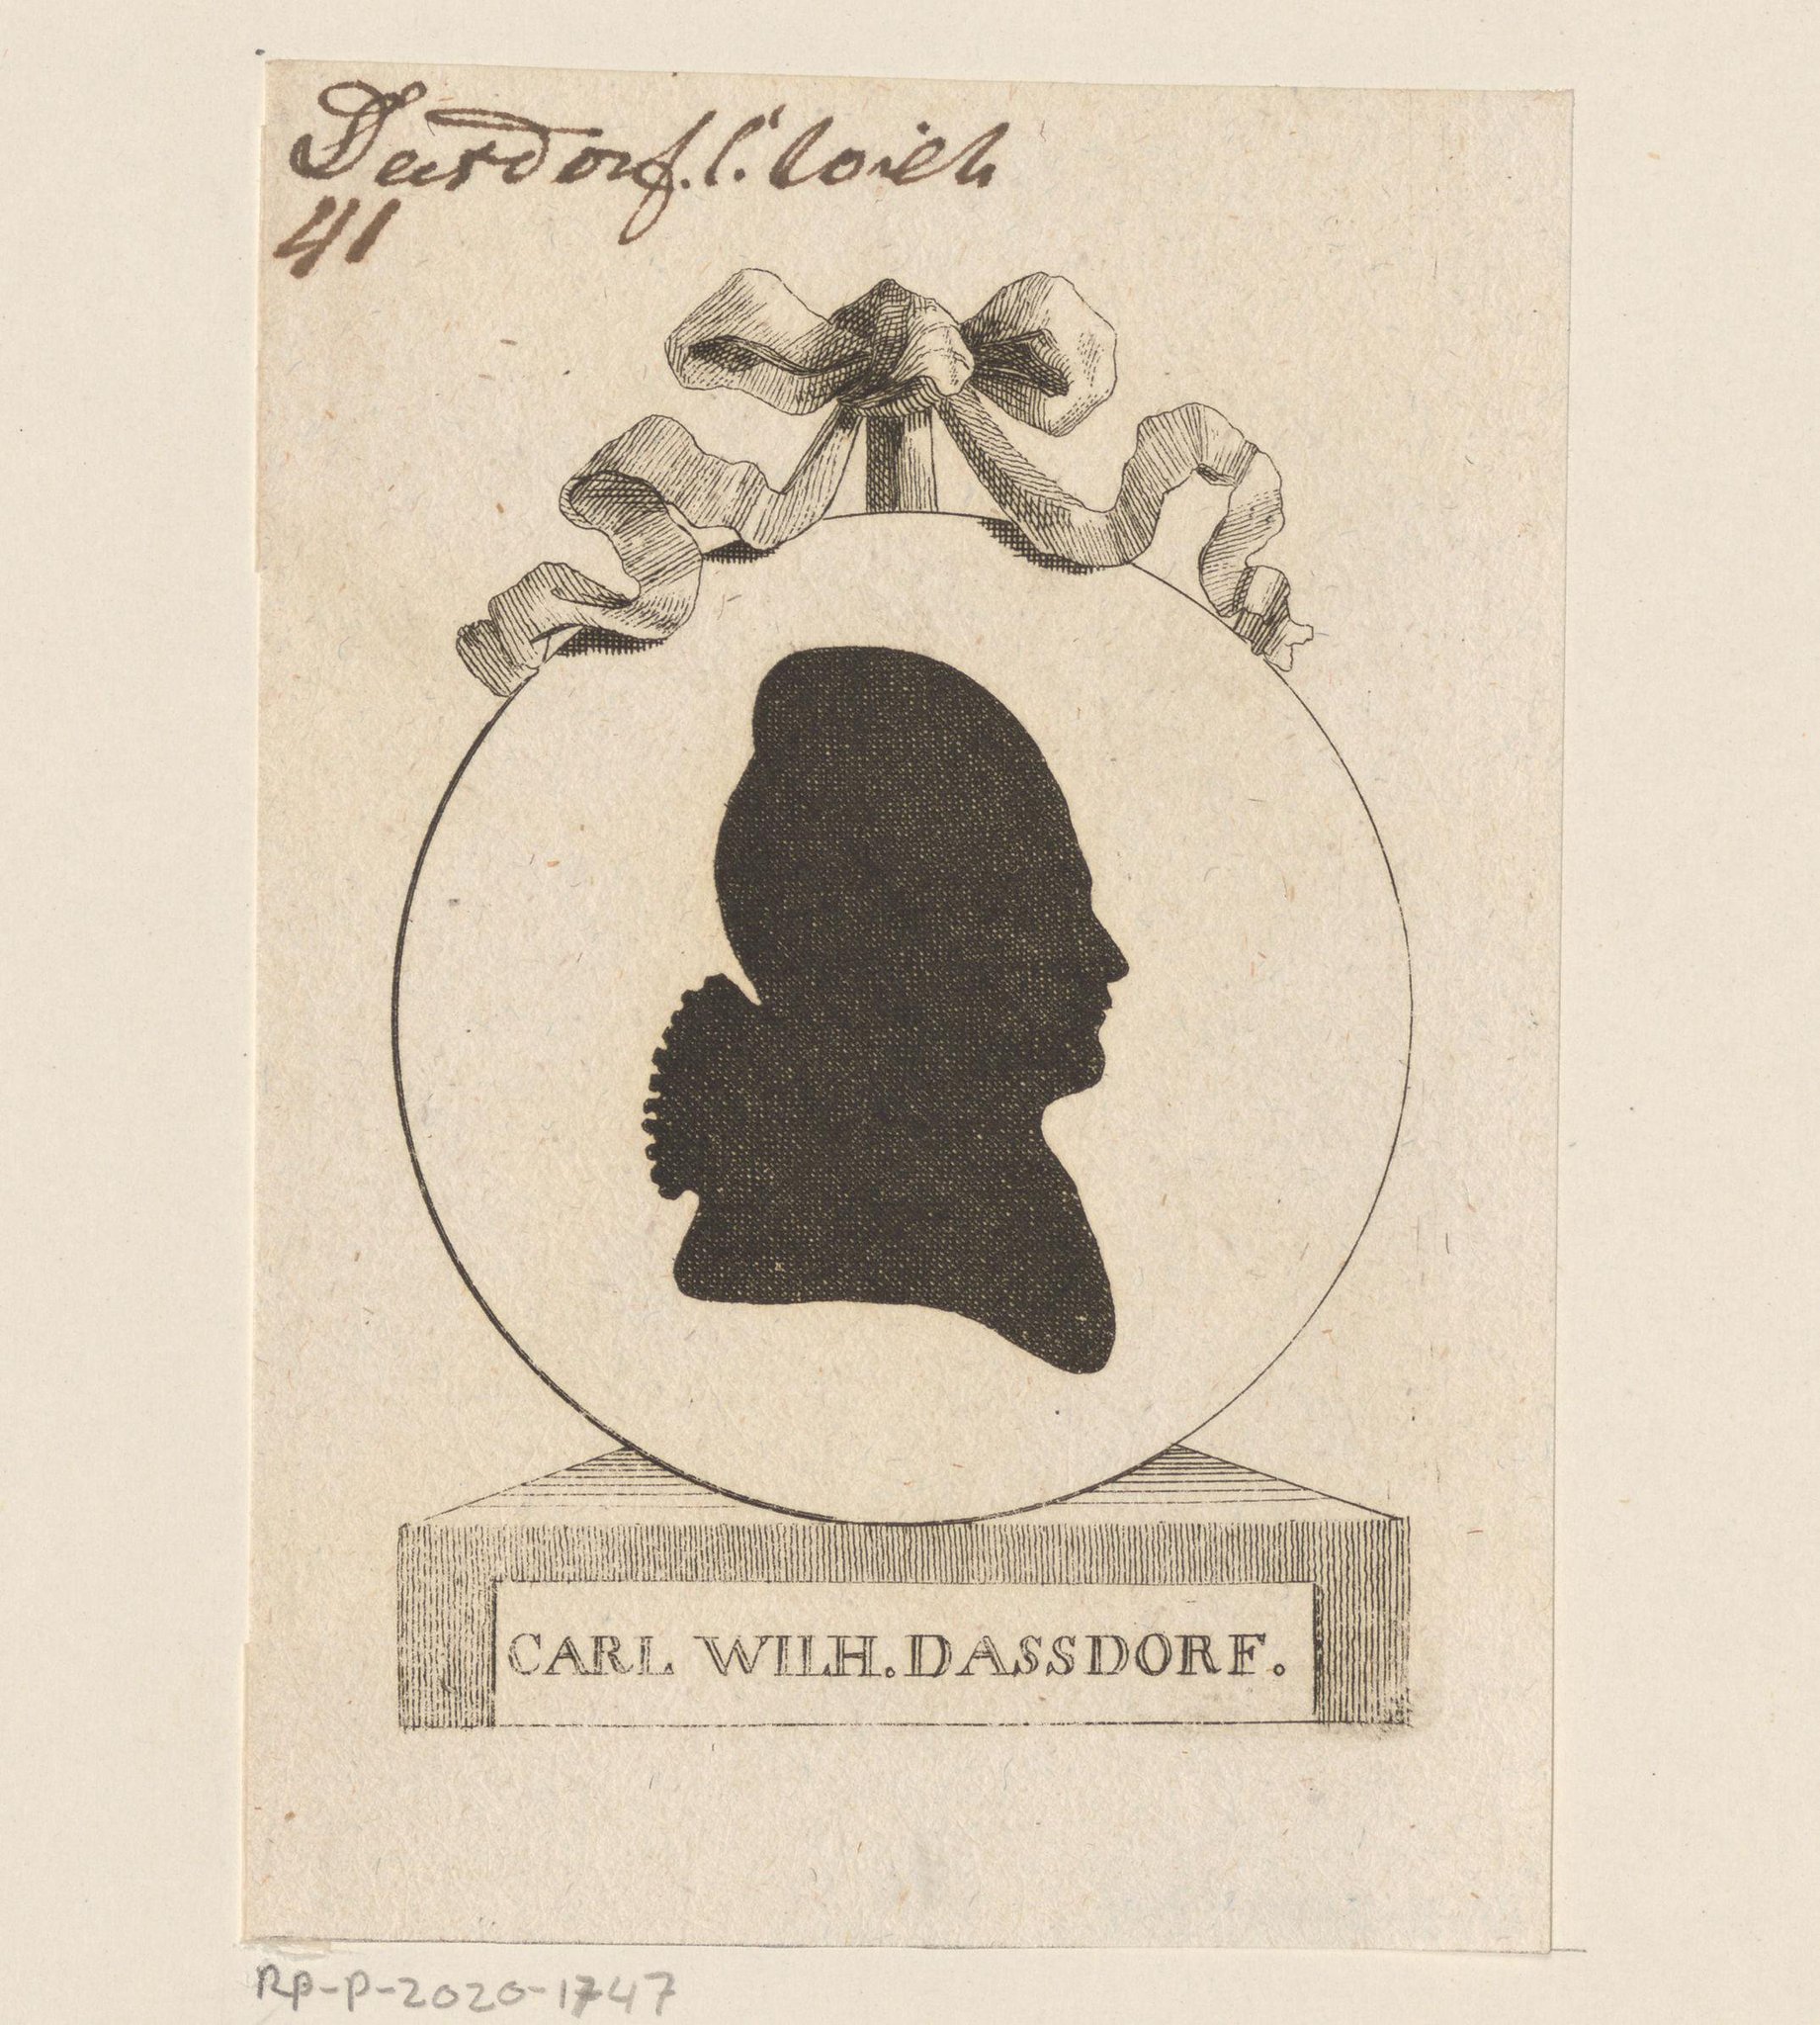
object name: print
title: Silhouetportret van Karl Wilhelm Daßdorf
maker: Anonymous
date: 1783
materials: paper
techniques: etching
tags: historical persons, portrait of a writer, adult man (+ sideview, profile), writer, poet, author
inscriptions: inscription: ‘Dec[...]dorf. l'. [...]/ 41’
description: Prent waarschijnlijk gebruikt in: Schattenrisse edler Teutschen. Aus dem Tagebuche eines physiognomischen Reisenden. Halle: Johann Christian Hendel, 1783, dl. 1.